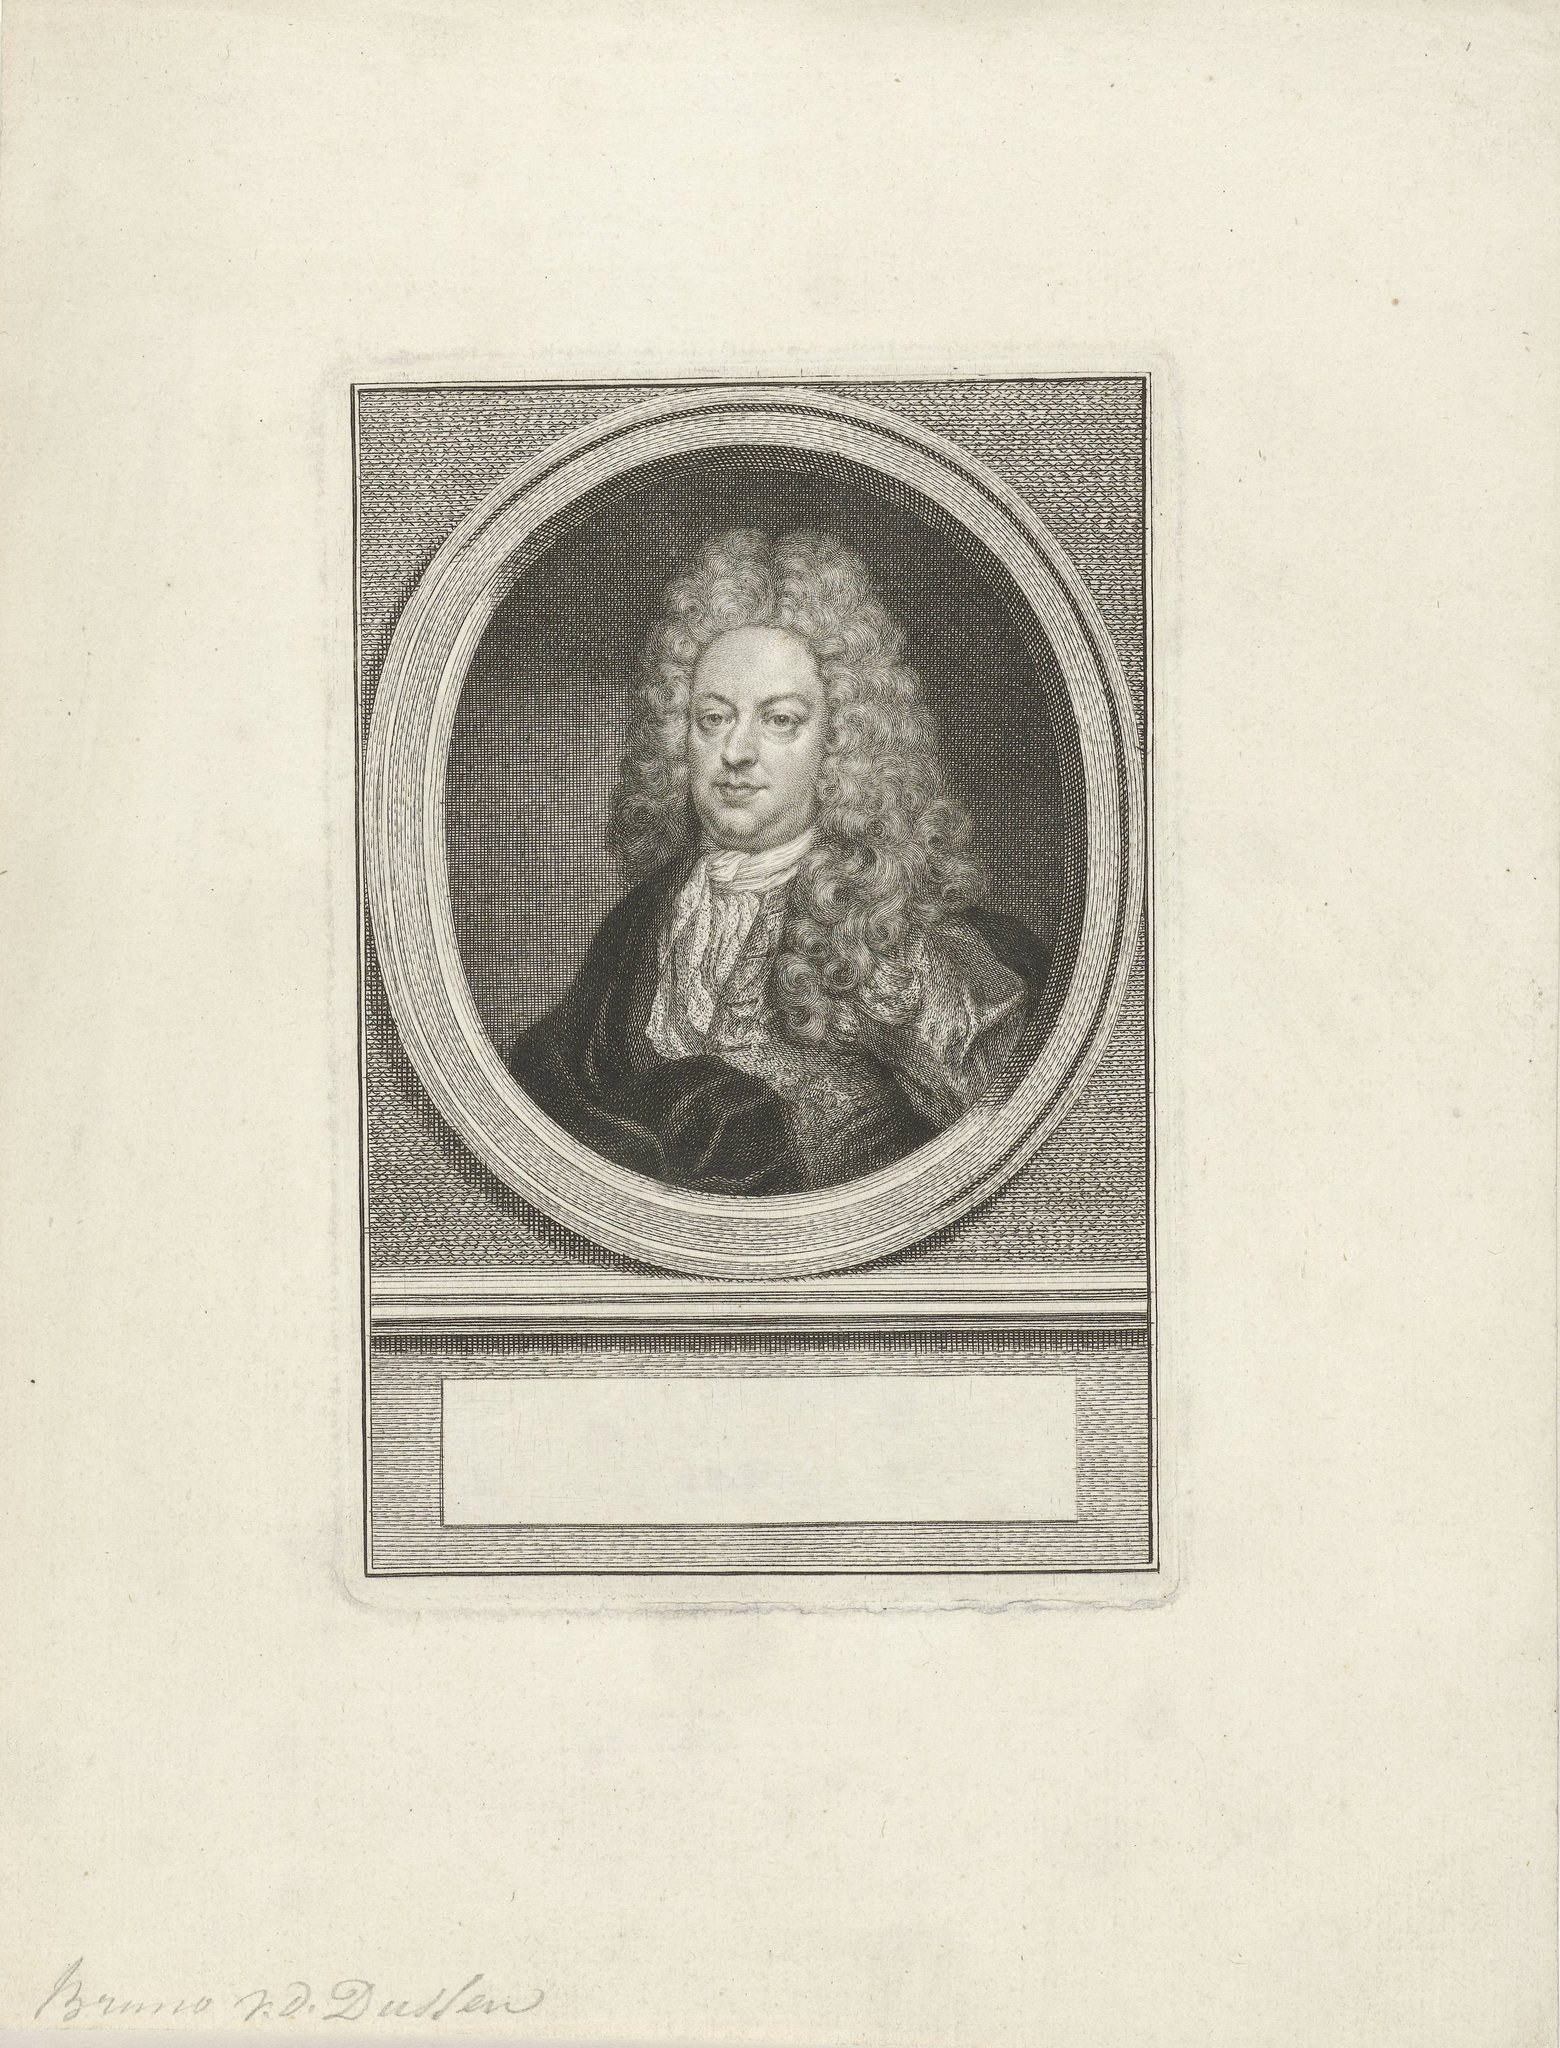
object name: print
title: Portret van Bruno van der Dussen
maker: jacob houbraken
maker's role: draughtsman, print maker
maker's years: 1698-1780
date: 1749-1780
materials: paper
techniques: engraving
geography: amsterdam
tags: mayor, bruno van der dussen, historical persons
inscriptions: collector's mark: Lugt 2228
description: Latere staat van deze prent is oorspronkelijk bedoeld als aanvulling op Jan Wagenaars ‘Vaderlandsche historie’* en was zo vanaf 1796 verkrijgbaar bij Johannes Allart te Amsterdam. Voor de advertentie waarin Allart de 60 portretten en 7 platen, allen gegraveerd door Houbraken, ter aanvulling op Wagenaars ‘Vaderlandsche historie’ aanbiedt, zie RP-P-OB-77.766. *Van dit werk zijn in de achttiende eeuw meerdere uitgaves verschenen, zoals: Wagenaar, Jan. Vaderlandsche historie, vervattende de geschiedenissen der Vereenigde Nederlanden (…). 21 delen. Amsterdam: Isaak Tirion, 1749-1759. Wagenaar, Jan. Vaderlandsche historie, vervattende de geschiedenissen der nu Vereenigde Nederlanden (…). 21 delen. Amsterdam: weduwe Isaak Tirion, 1770. Wagenaar, Jan. Vaderlandsche historie, vervattende de geschiedenissen der nu Vereenigde Nederlanden (…). 21 delen. Amsterdam, Leiden, Dordrecht en Harlingen: P. Schouten e.a., 1782. Wagenaar, Jan. Vaderlandsche historie, vervattende de geschiedenissen der nu Vereenigde Nederlanden (…). 21 delen. Amsterdam: Johannes Allart, 1790-1796.